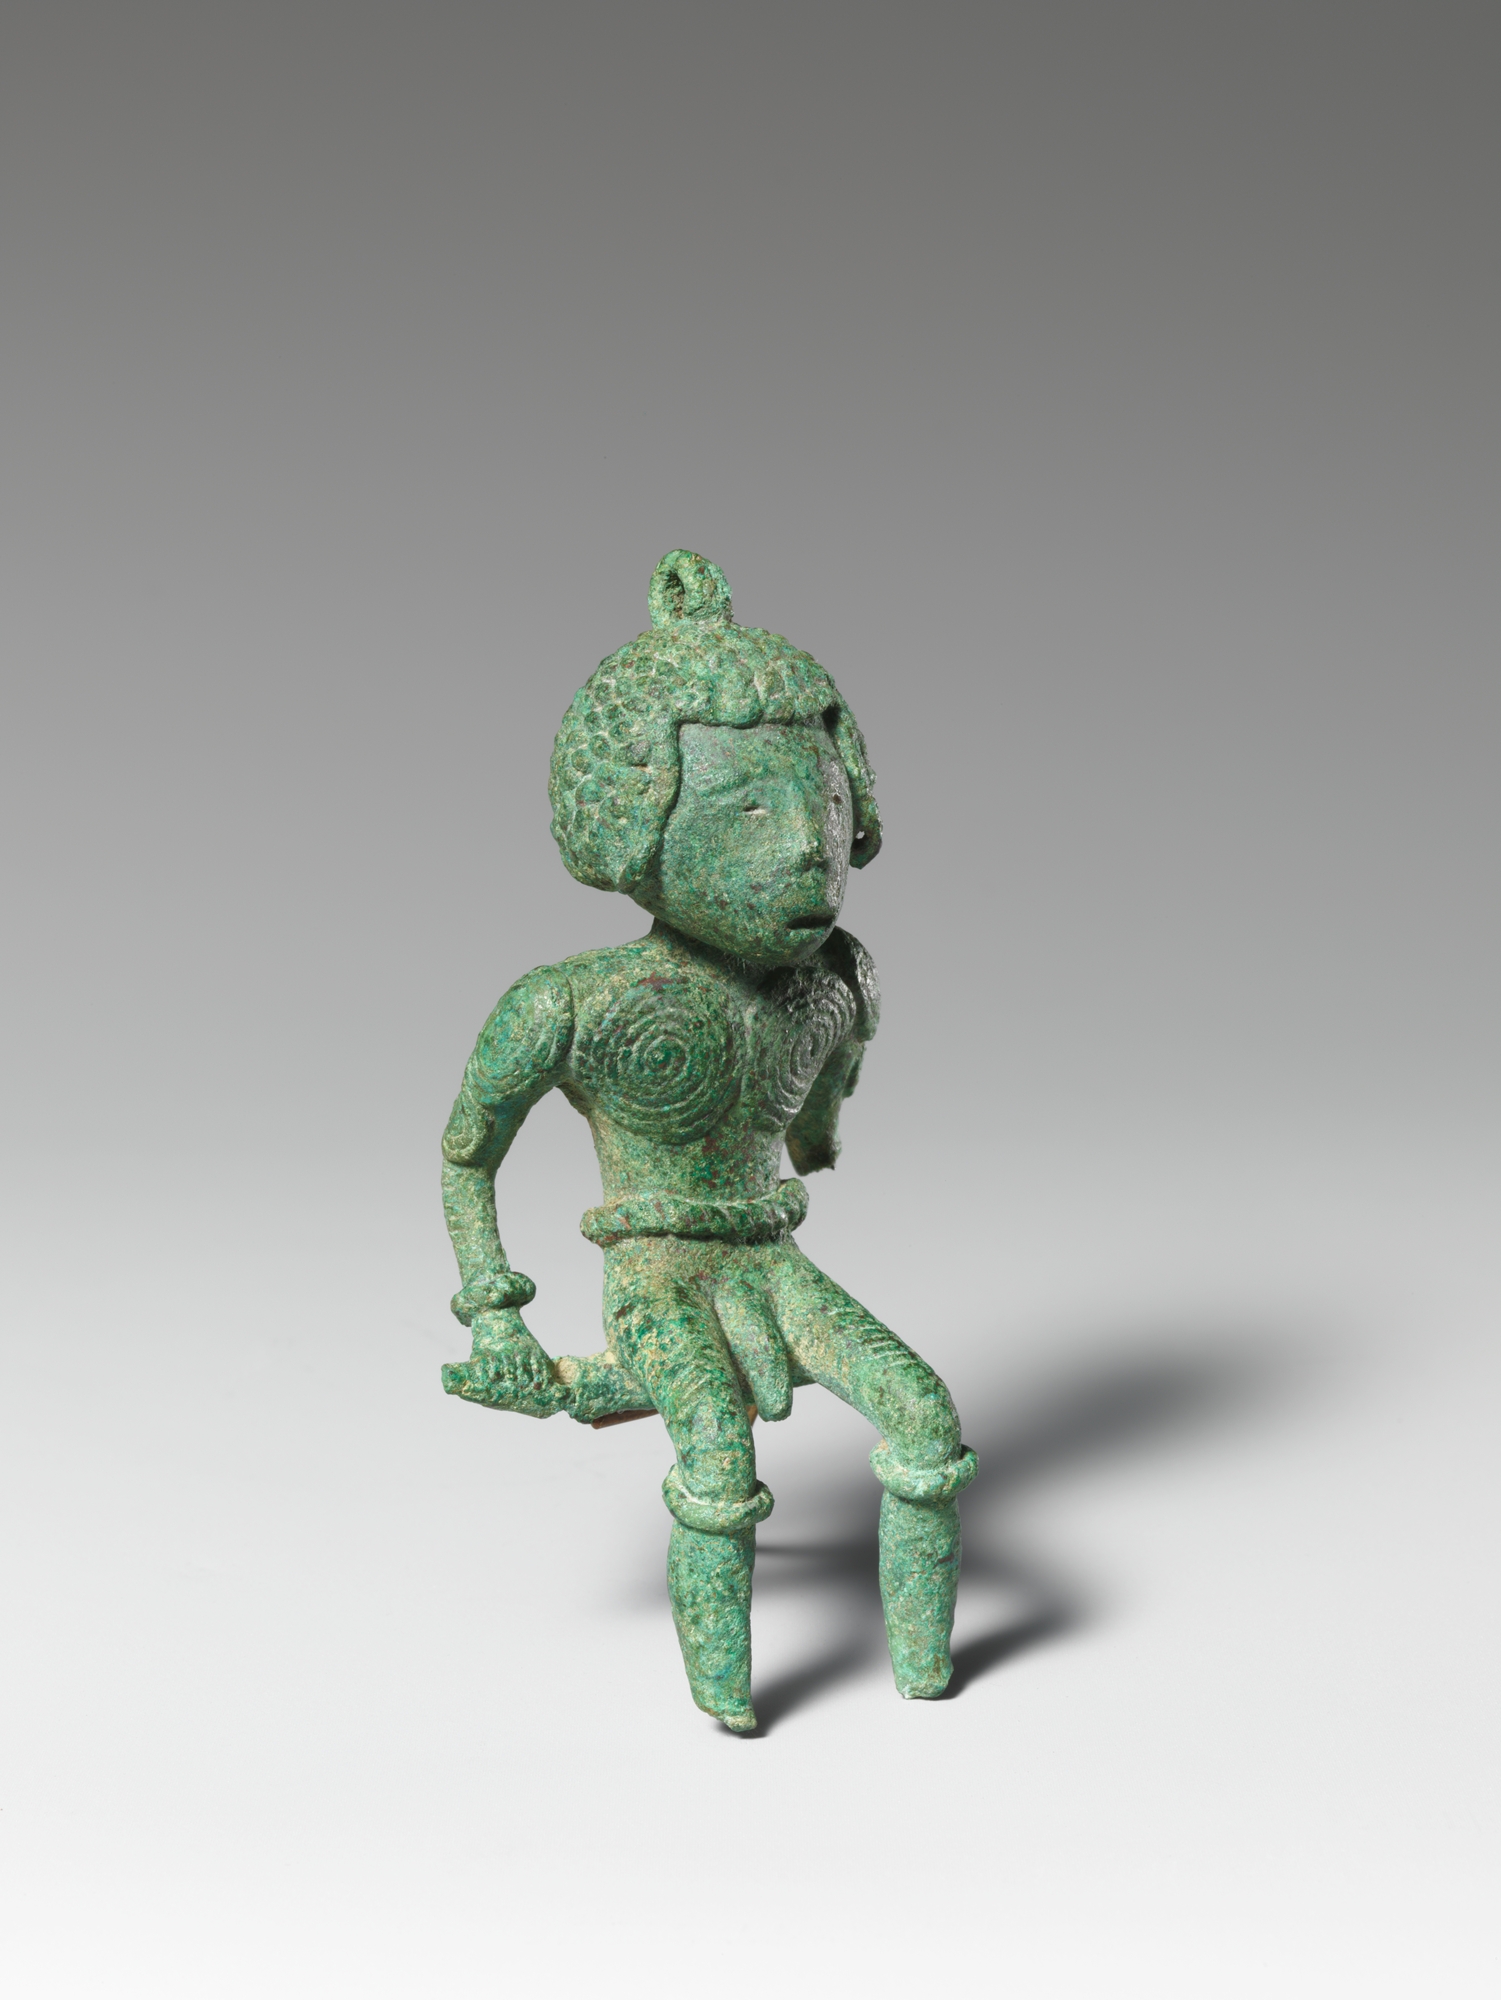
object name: figure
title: Seated Male Figure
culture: vietnamese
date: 500 BCE-300 CE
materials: bronze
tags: men